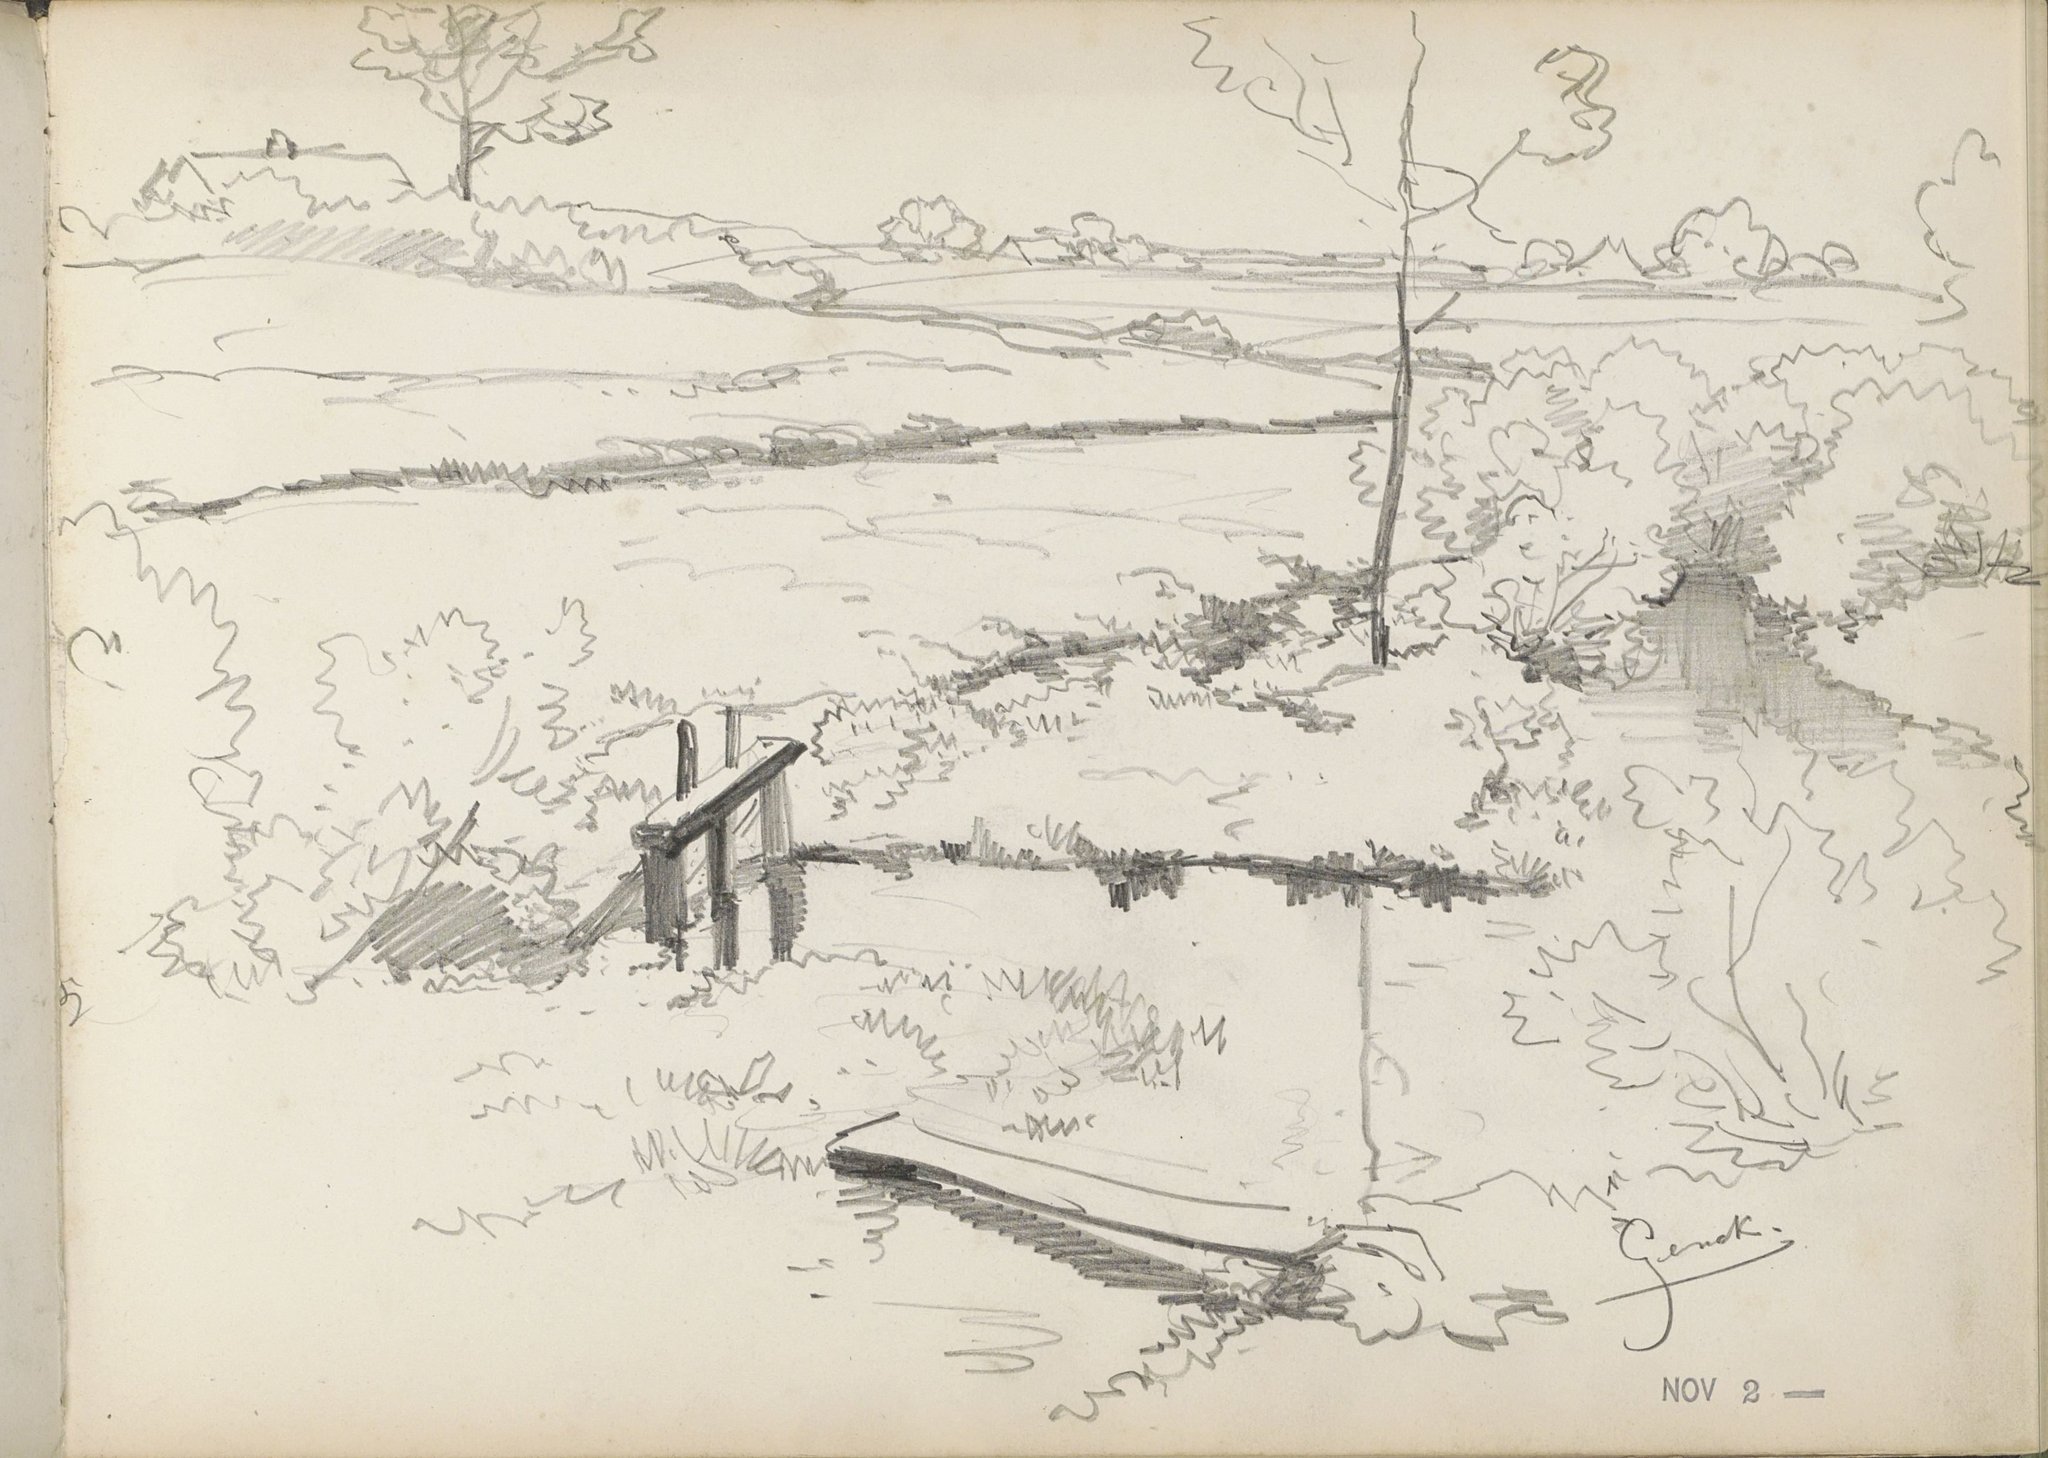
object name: sketchbook leaf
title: Landschap met water bij Genk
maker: willem roelofs (i)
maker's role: draughtsman, painter, print maker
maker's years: 1822-1897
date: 1846-1851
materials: paper, pencil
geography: genk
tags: landscapes with waters, waterscapes, seascapes (in the temperate zone)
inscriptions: annotation: ‘Genck.’, date: ‘NOV 2 __’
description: Blad 24 recto uit een schetsboek met 25 bladen.